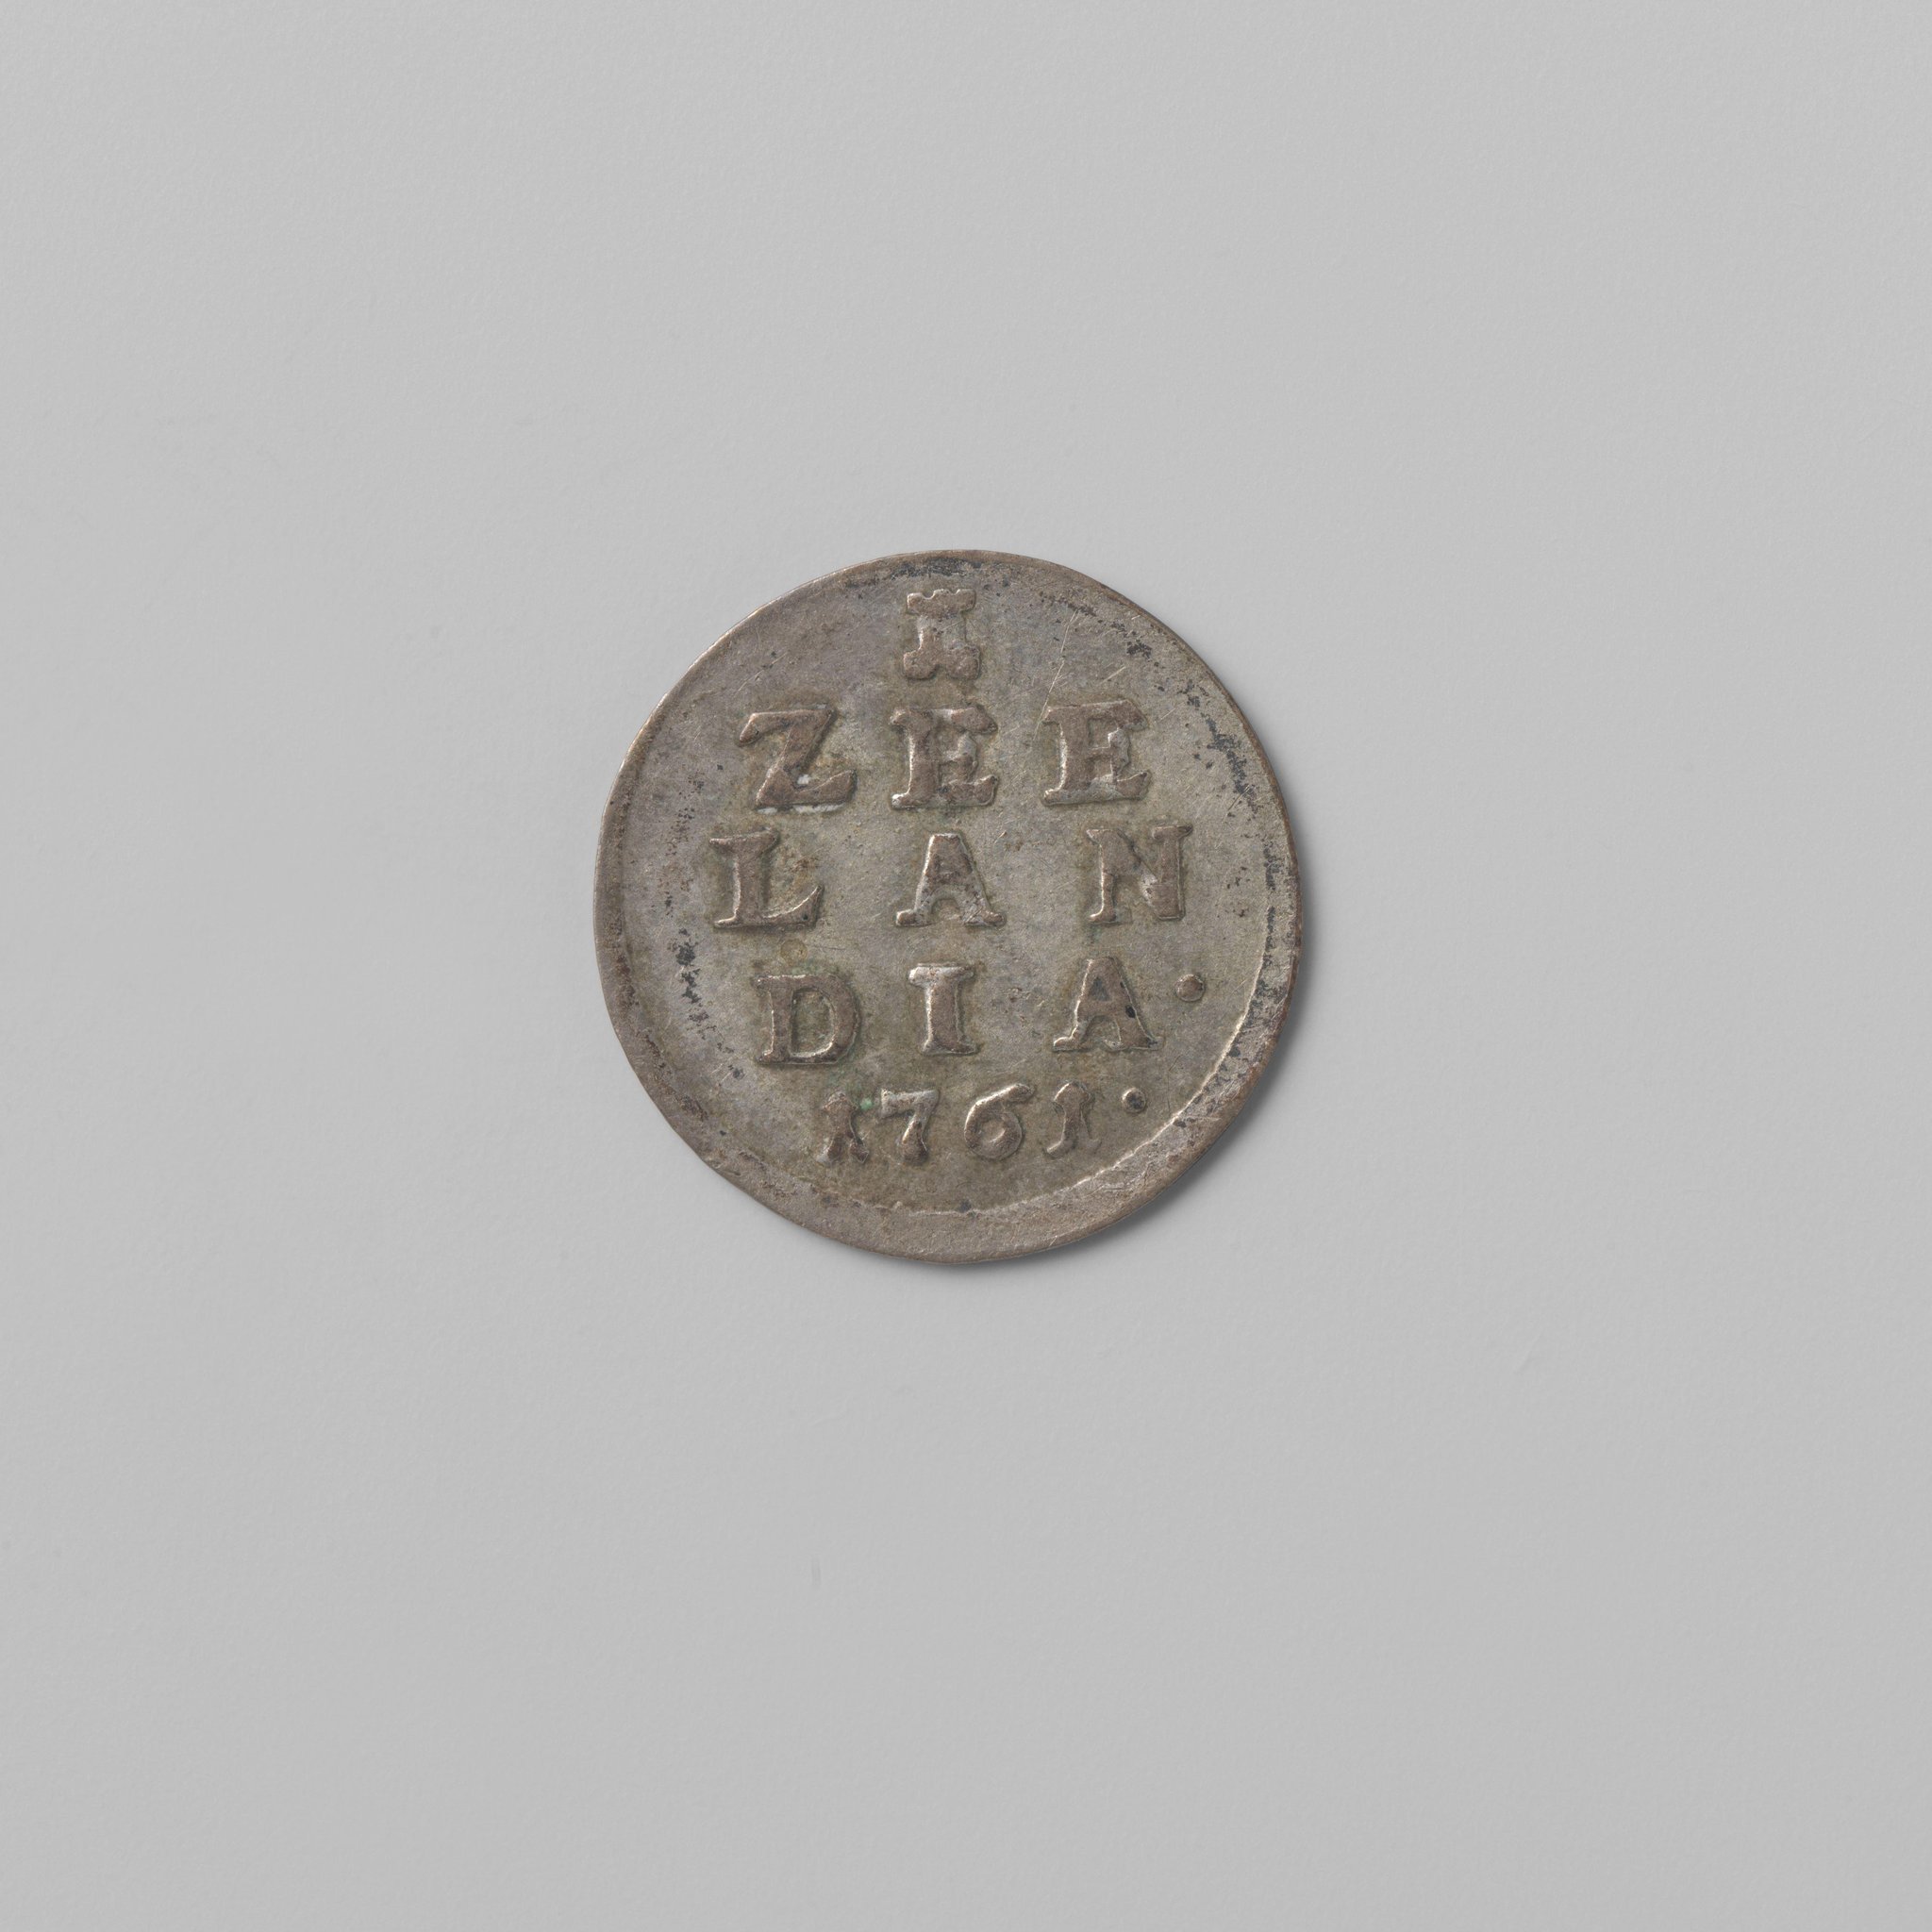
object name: coin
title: Zeeland, stuiver, 1761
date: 1761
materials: silver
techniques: striking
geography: middelburg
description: Zilveen munt. Voorzijde: Keerzijde: opschrift in drie regels, waarboven muntteken burcht tussen twee rozetten en waaronder jaartal. Keerzijde: binnen lauwerkrans tussen waarde-aanduiding pijlenbundel.